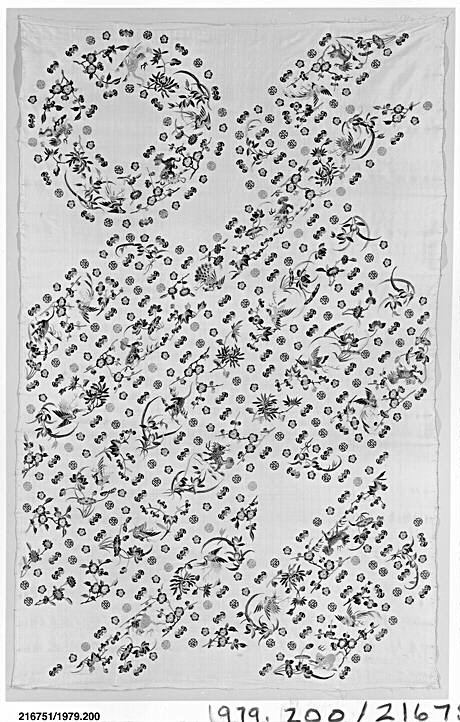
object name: length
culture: chinese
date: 1900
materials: metal thread, silk